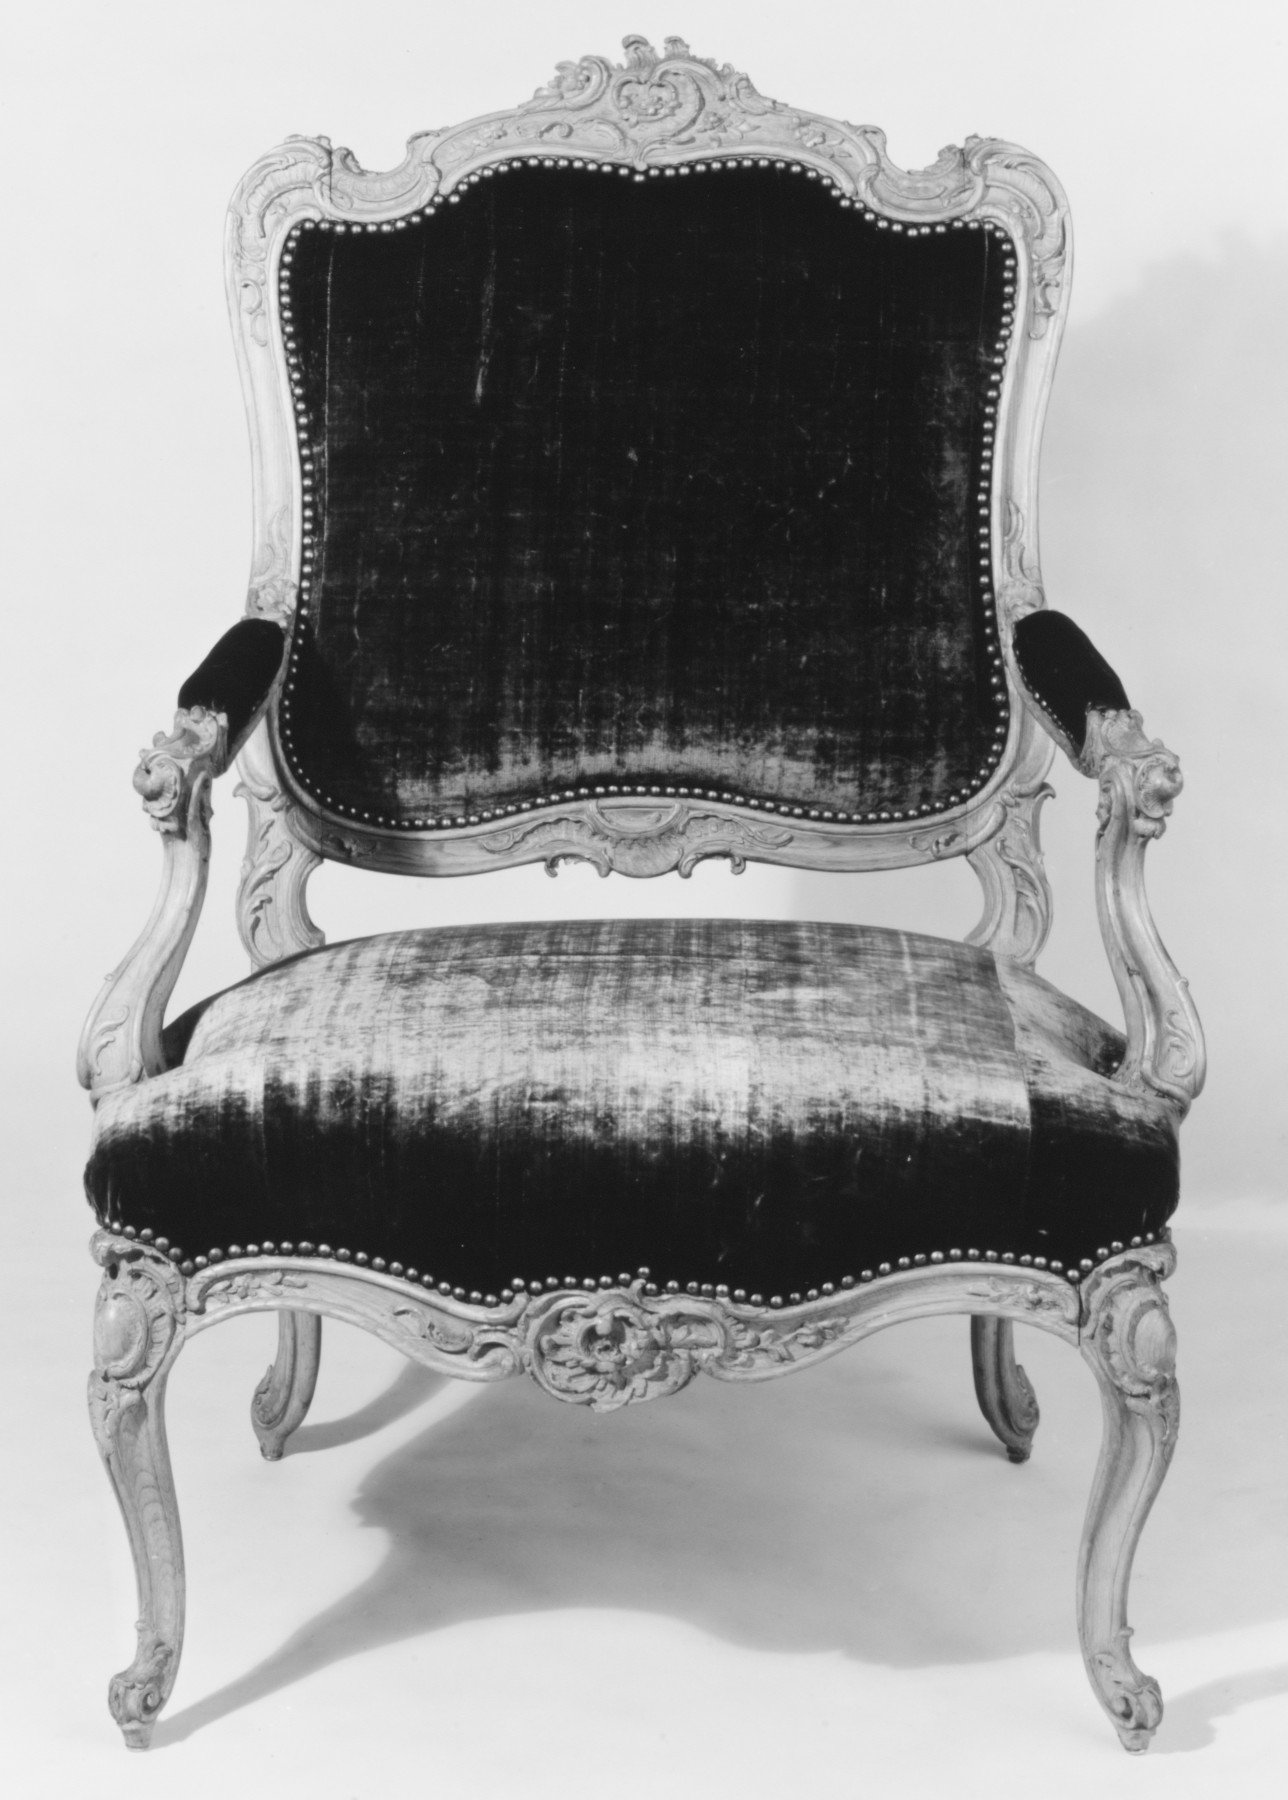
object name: armchair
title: Armchair (one of a pair)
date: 1760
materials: wood